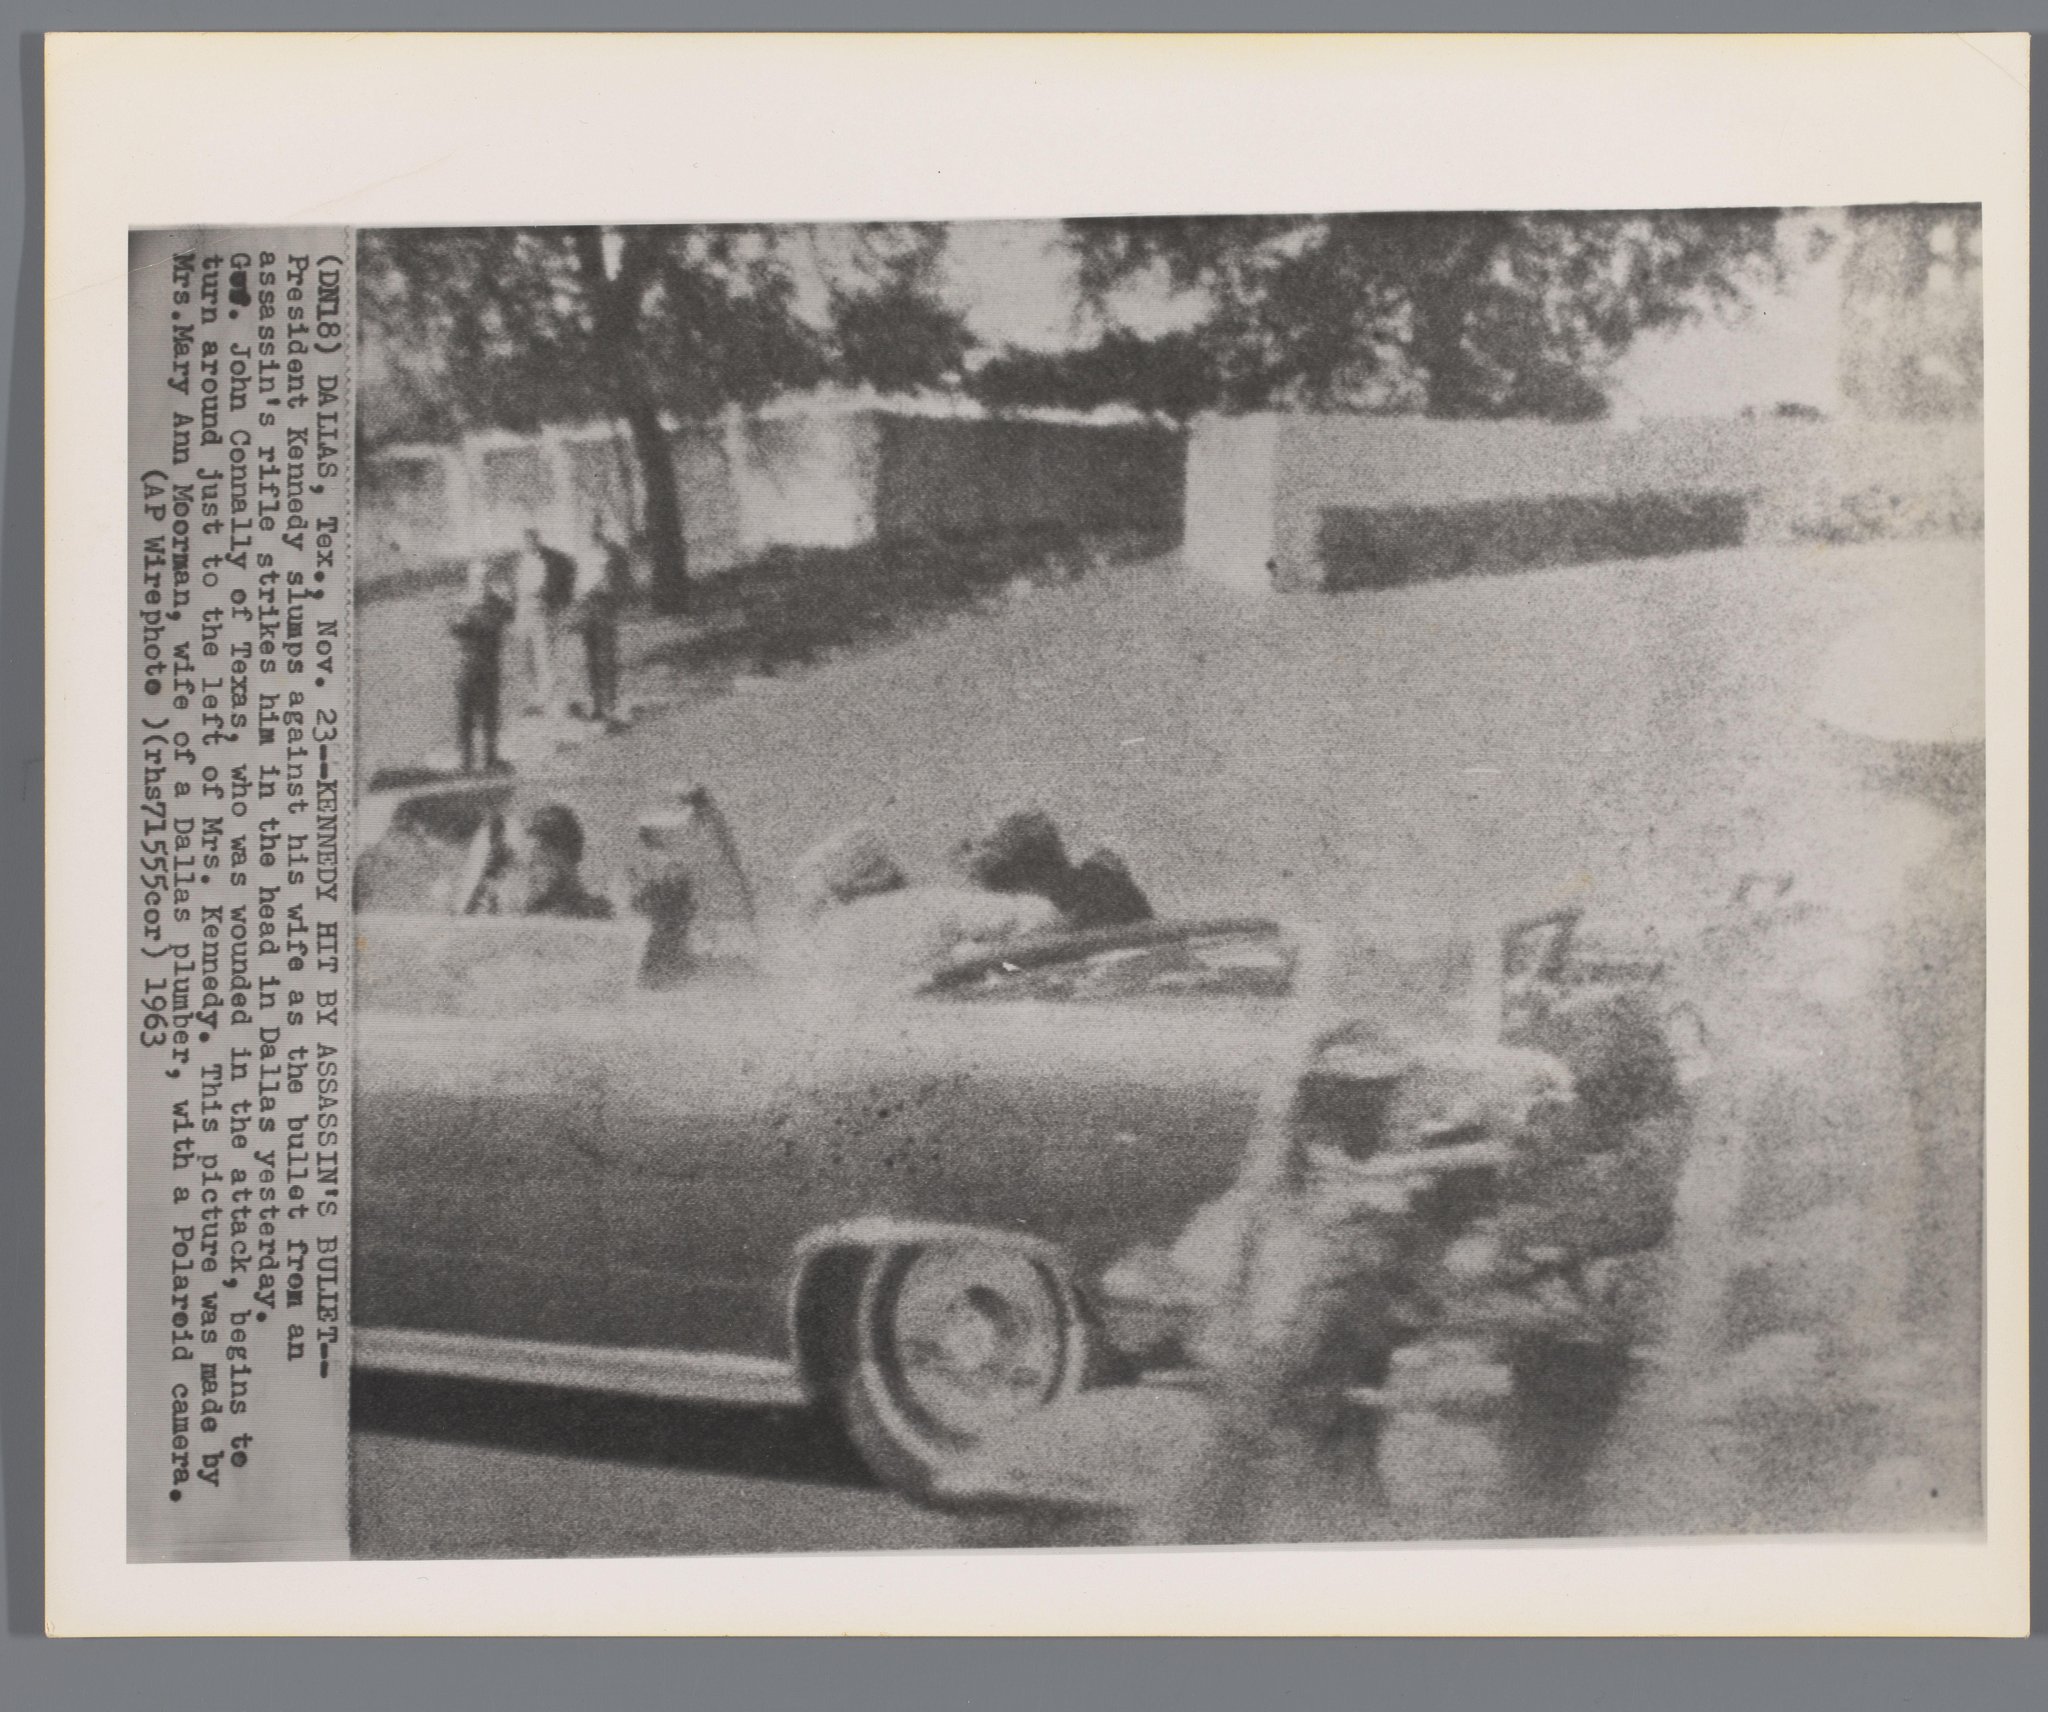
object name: news photograph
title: Fotoreproductie naar een Polaroid-opname van de moord op John F. Kennedy in Dallas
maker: mary ann moorman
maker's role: fotograaf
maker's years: 1932-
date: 1963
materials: paper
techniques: gelatin silver print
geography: dallas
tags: attempt, political murder, assassination of john f. kennedy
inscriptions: inscription: ‘NOTICE/ This picture is the [...]/ ASSOCIATED PRESS/ WIREPHOTO/ [...]’